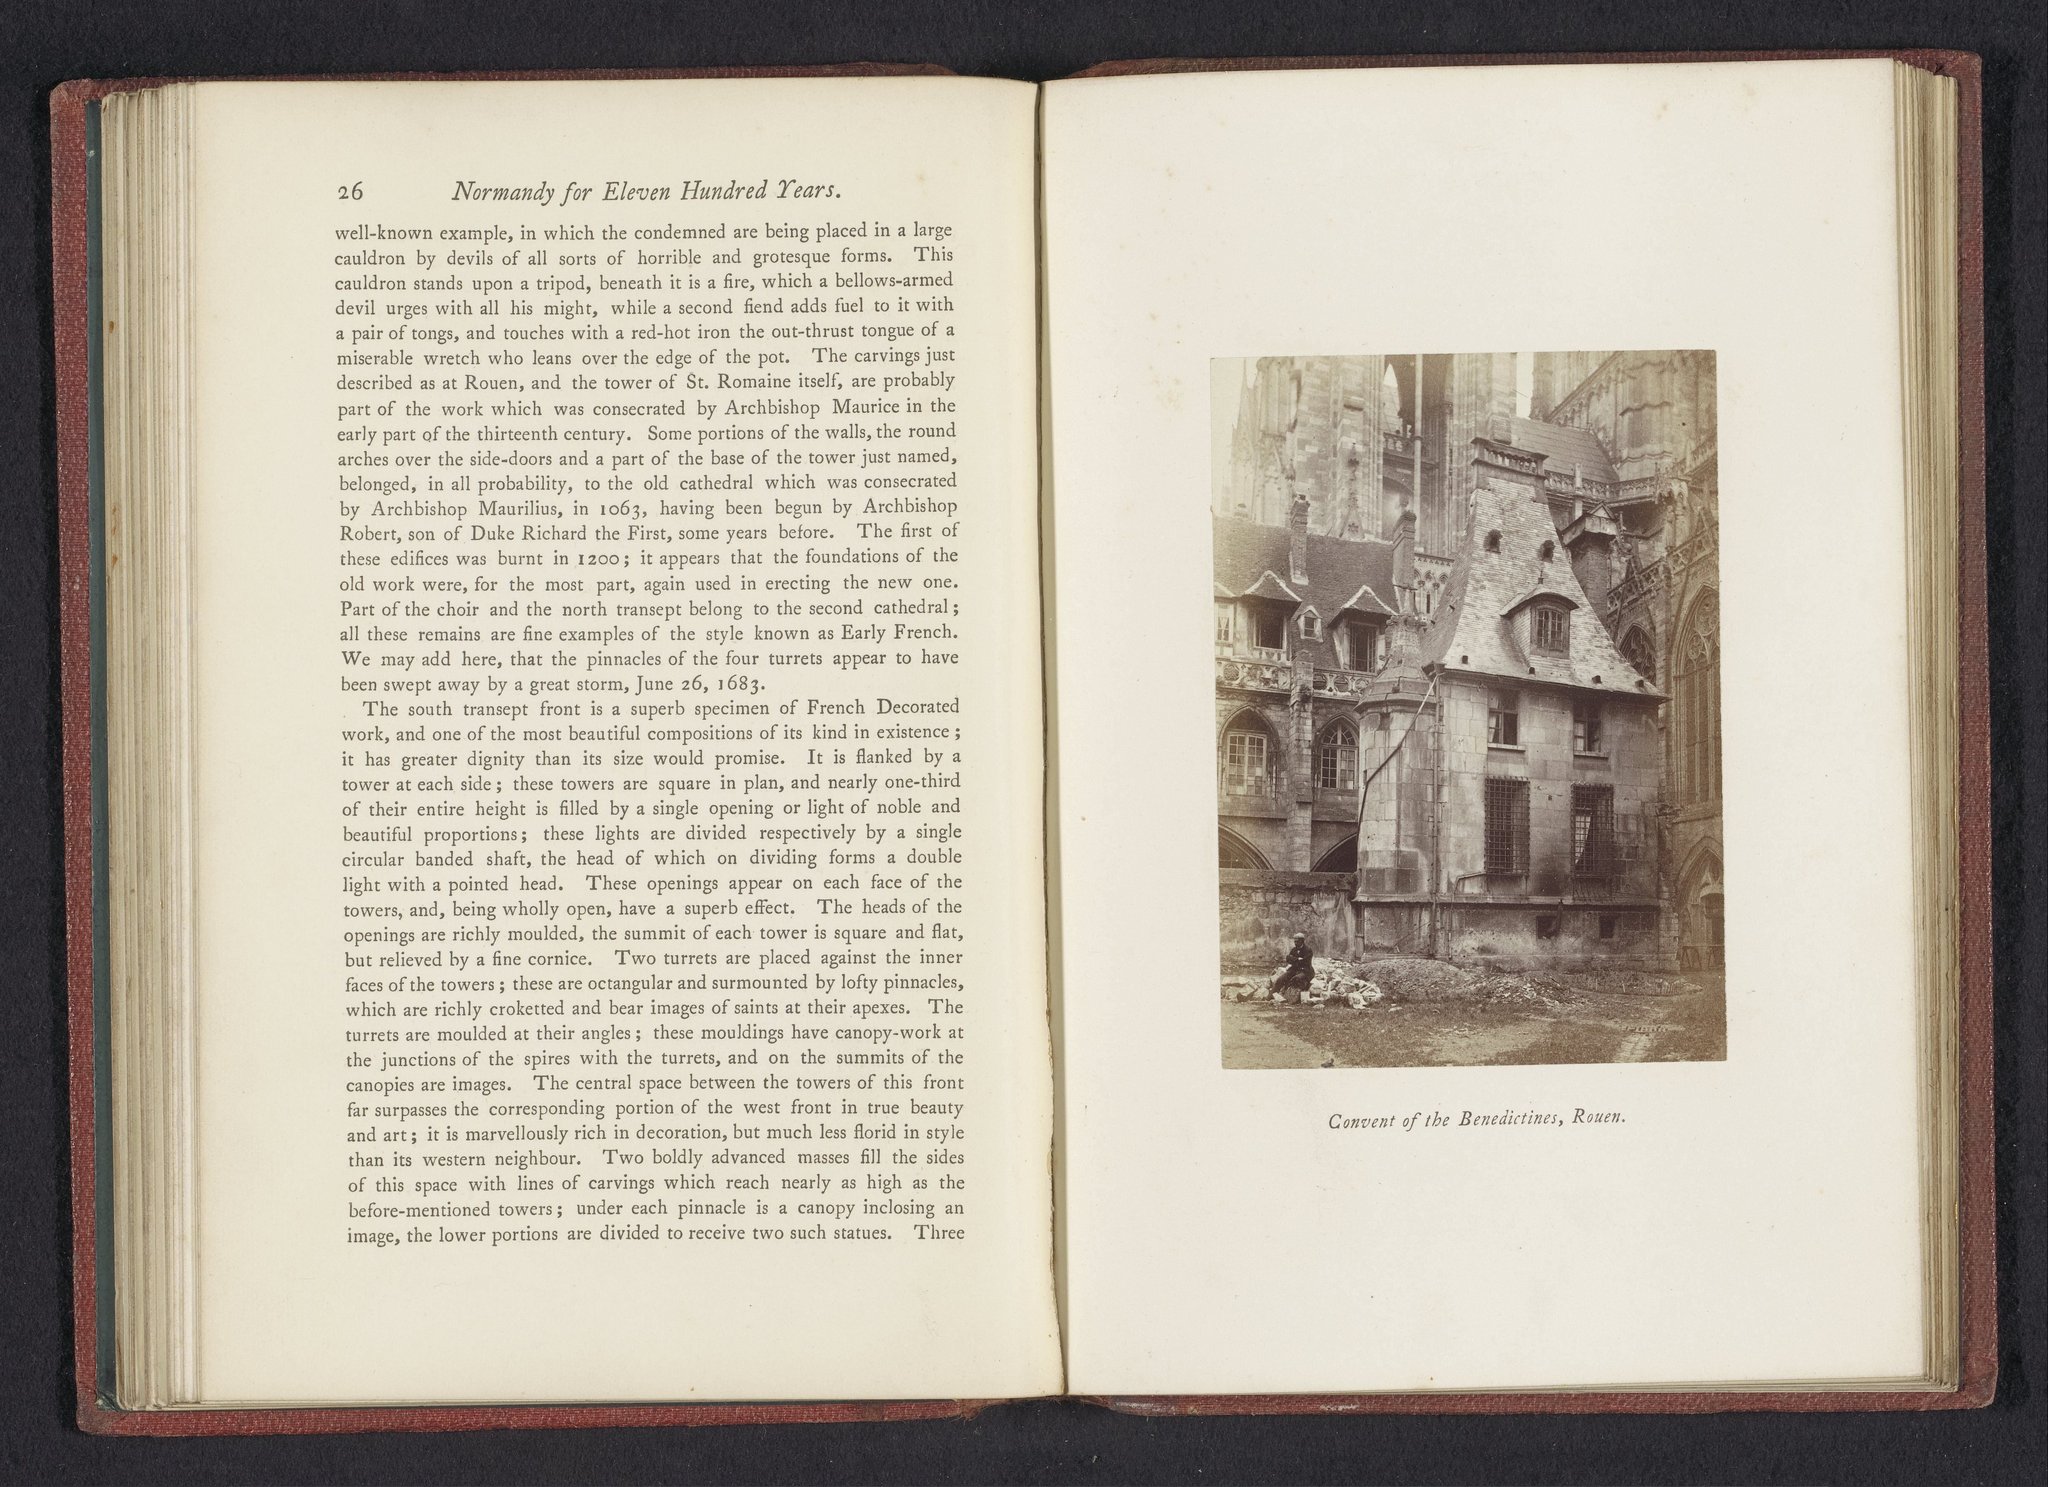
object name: photograph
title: Convent of the Benedictines, Rouen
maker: joseph cundall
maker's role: fotograaf, schrijver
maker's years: 1818-1895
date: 1855-1865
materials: photographic support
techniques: albumen print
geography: rouen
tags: abbey, monastery, convent ~ roman catholic church, façade (of house or building)